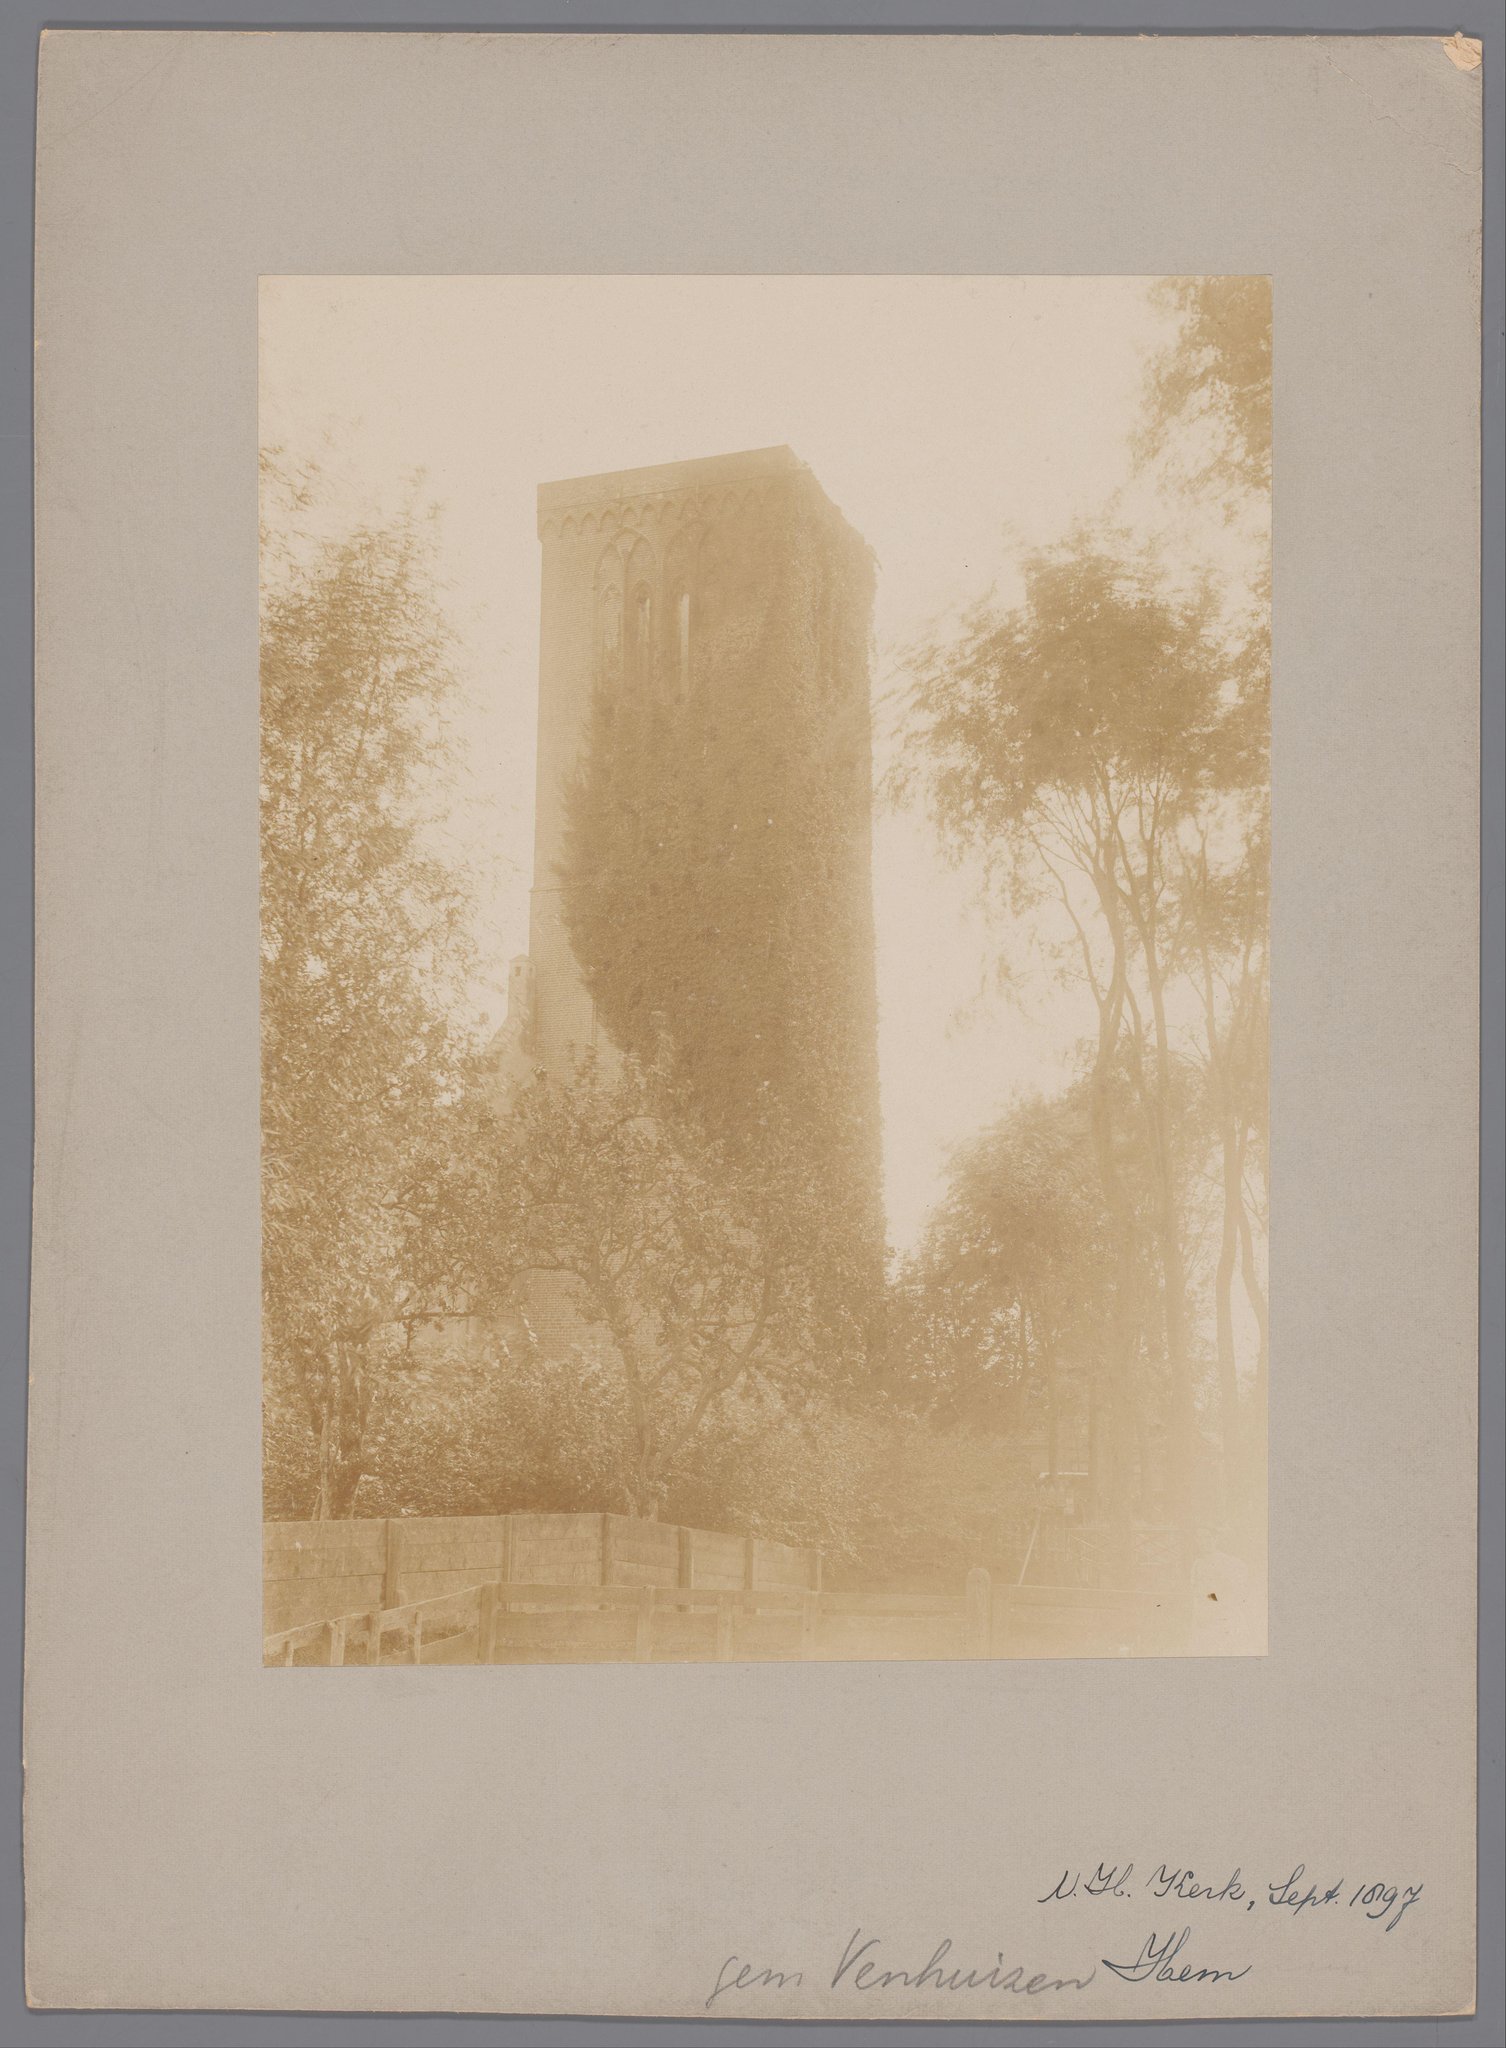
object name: photograph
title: Toren van de Nederlands-hervormde Kerk te Hem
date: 1897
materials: cardboard, photographic support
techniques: collodion silver print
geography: hem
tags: church (exterior), tower (of house or building)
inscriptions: annotation: ‘gem Venhuizen’, annotation: ‘N.H. Kerk, sept. 1897/ Hem’, annotation: ‘Hem gem Venhuizen (N.H.)/ N.W. zijde v/d toren/ sept 1897’